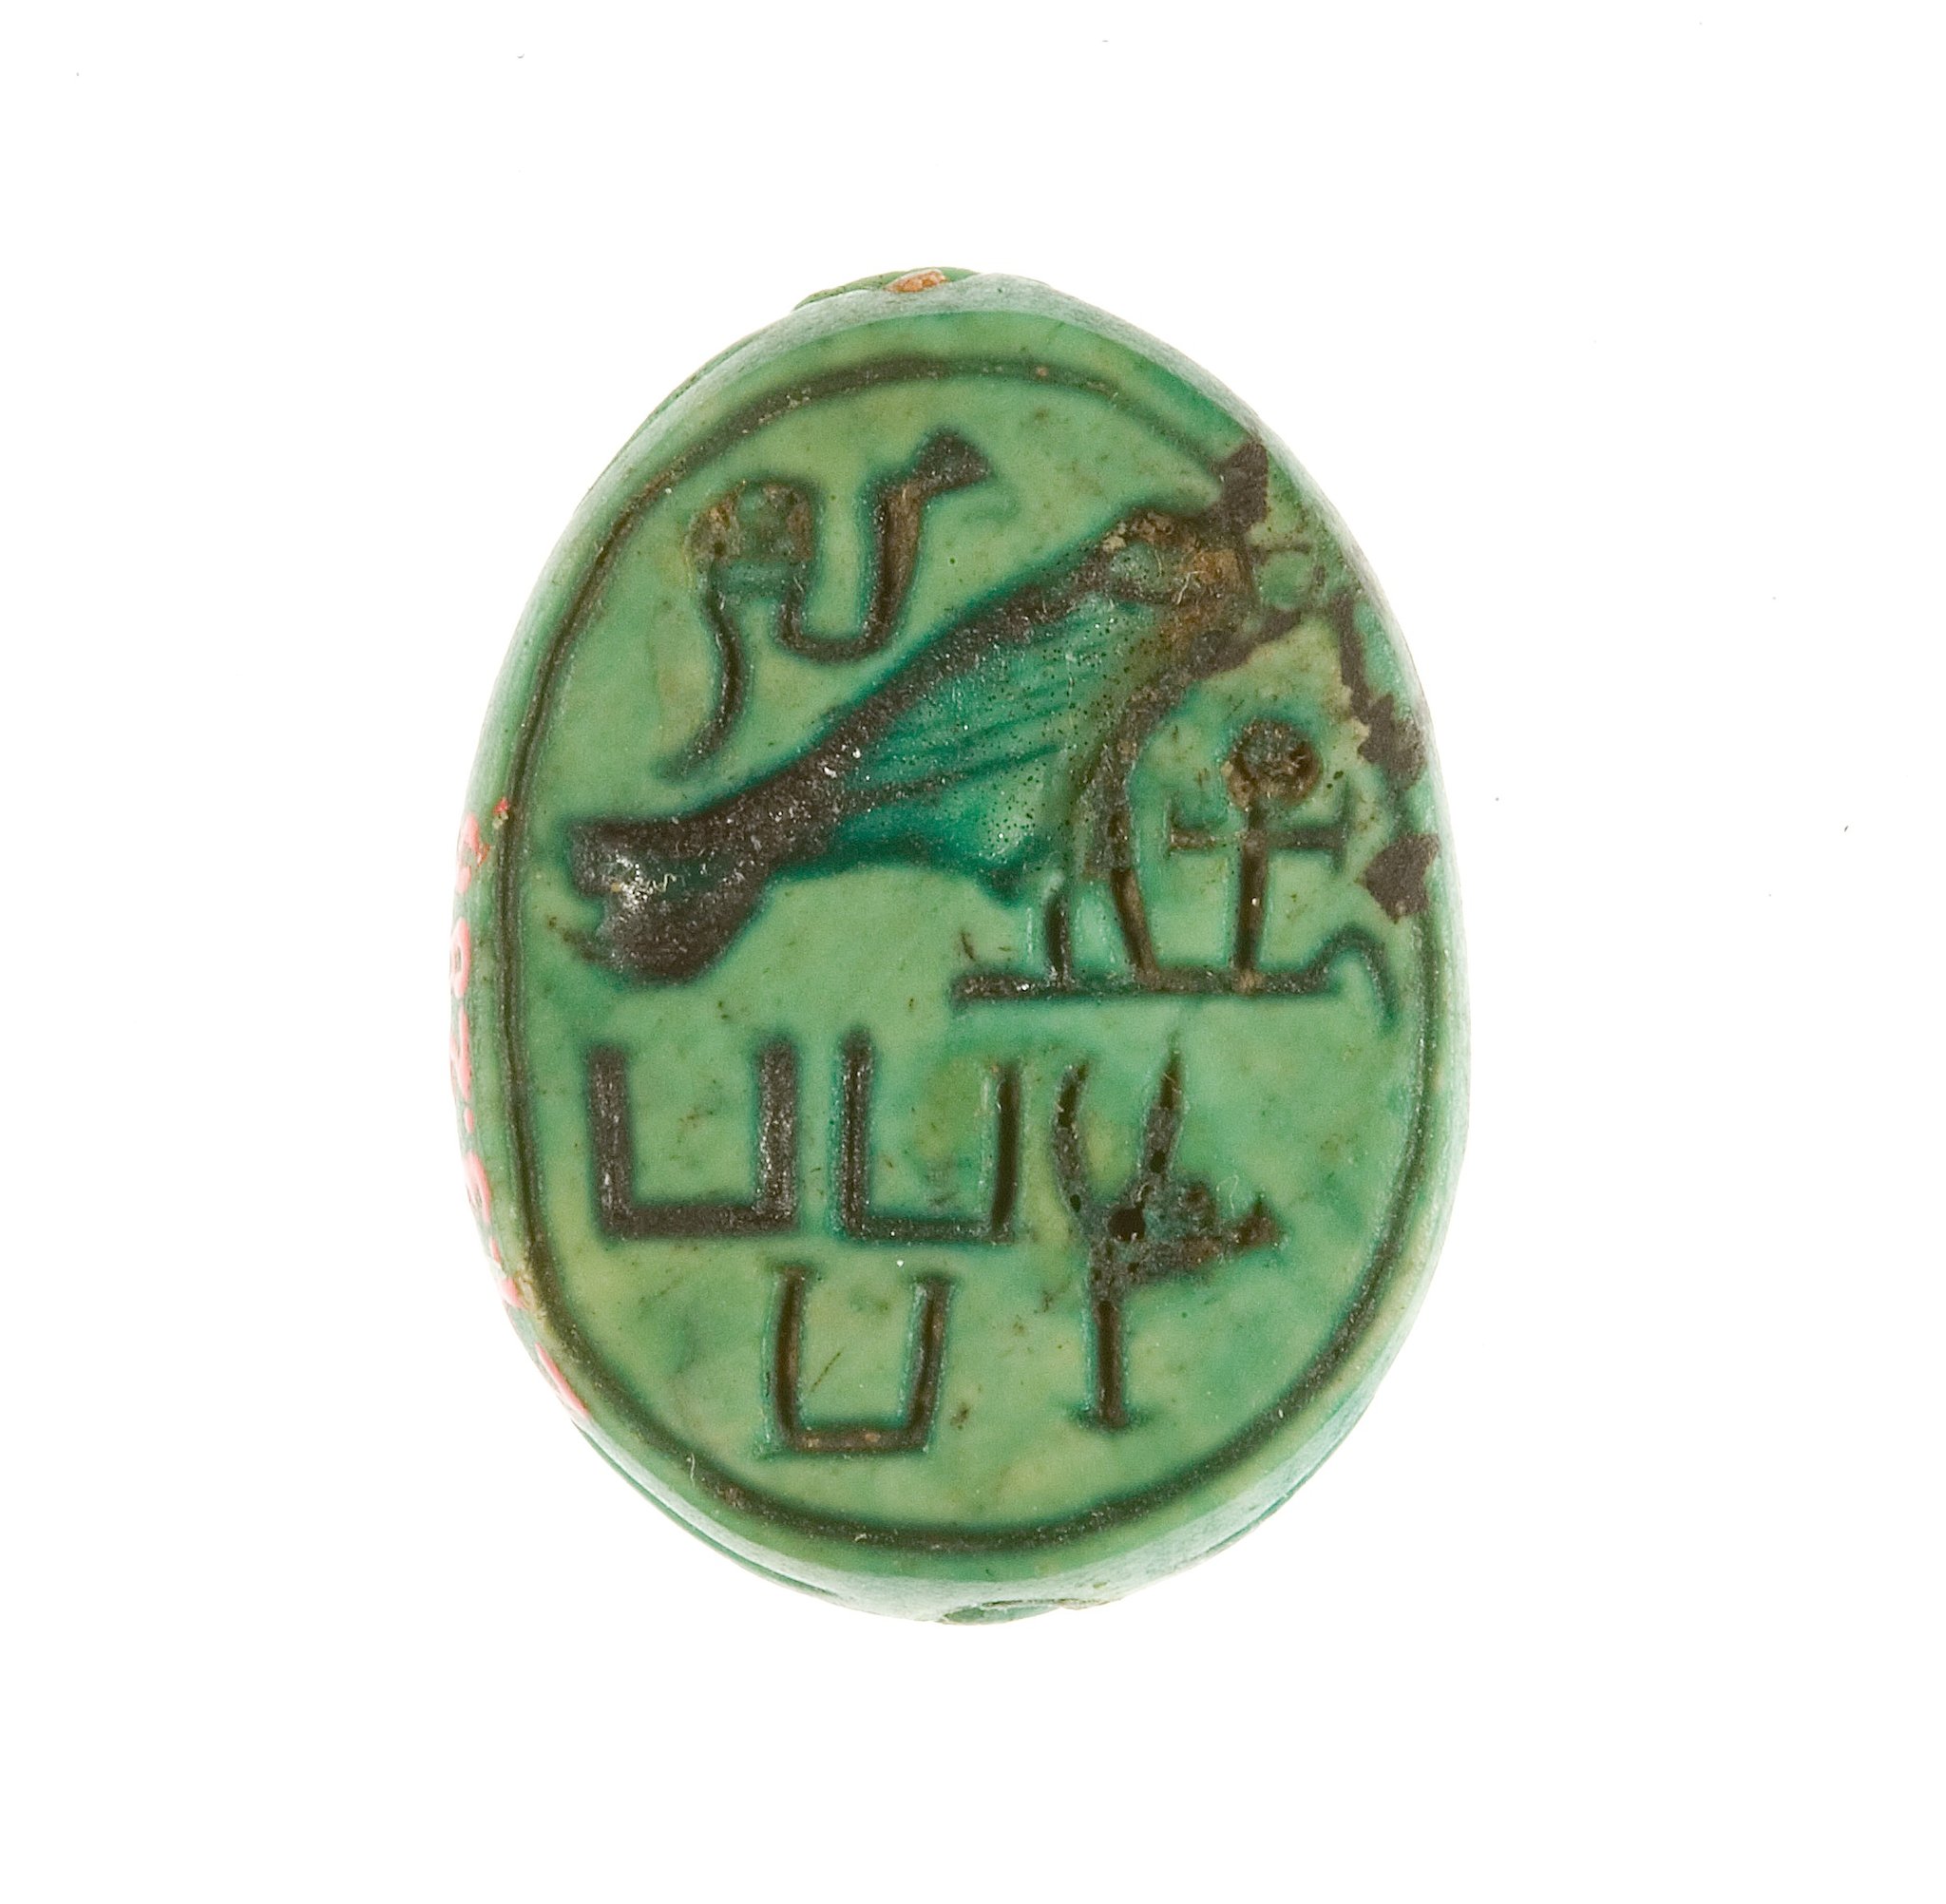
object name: scarab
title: Scarab Inscribed for the Living Horus Wosretkau (Hatshepsut)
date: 1479-1458 BCE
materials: stone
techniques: glazing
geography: egypt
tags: hieroglyphs,scarabs